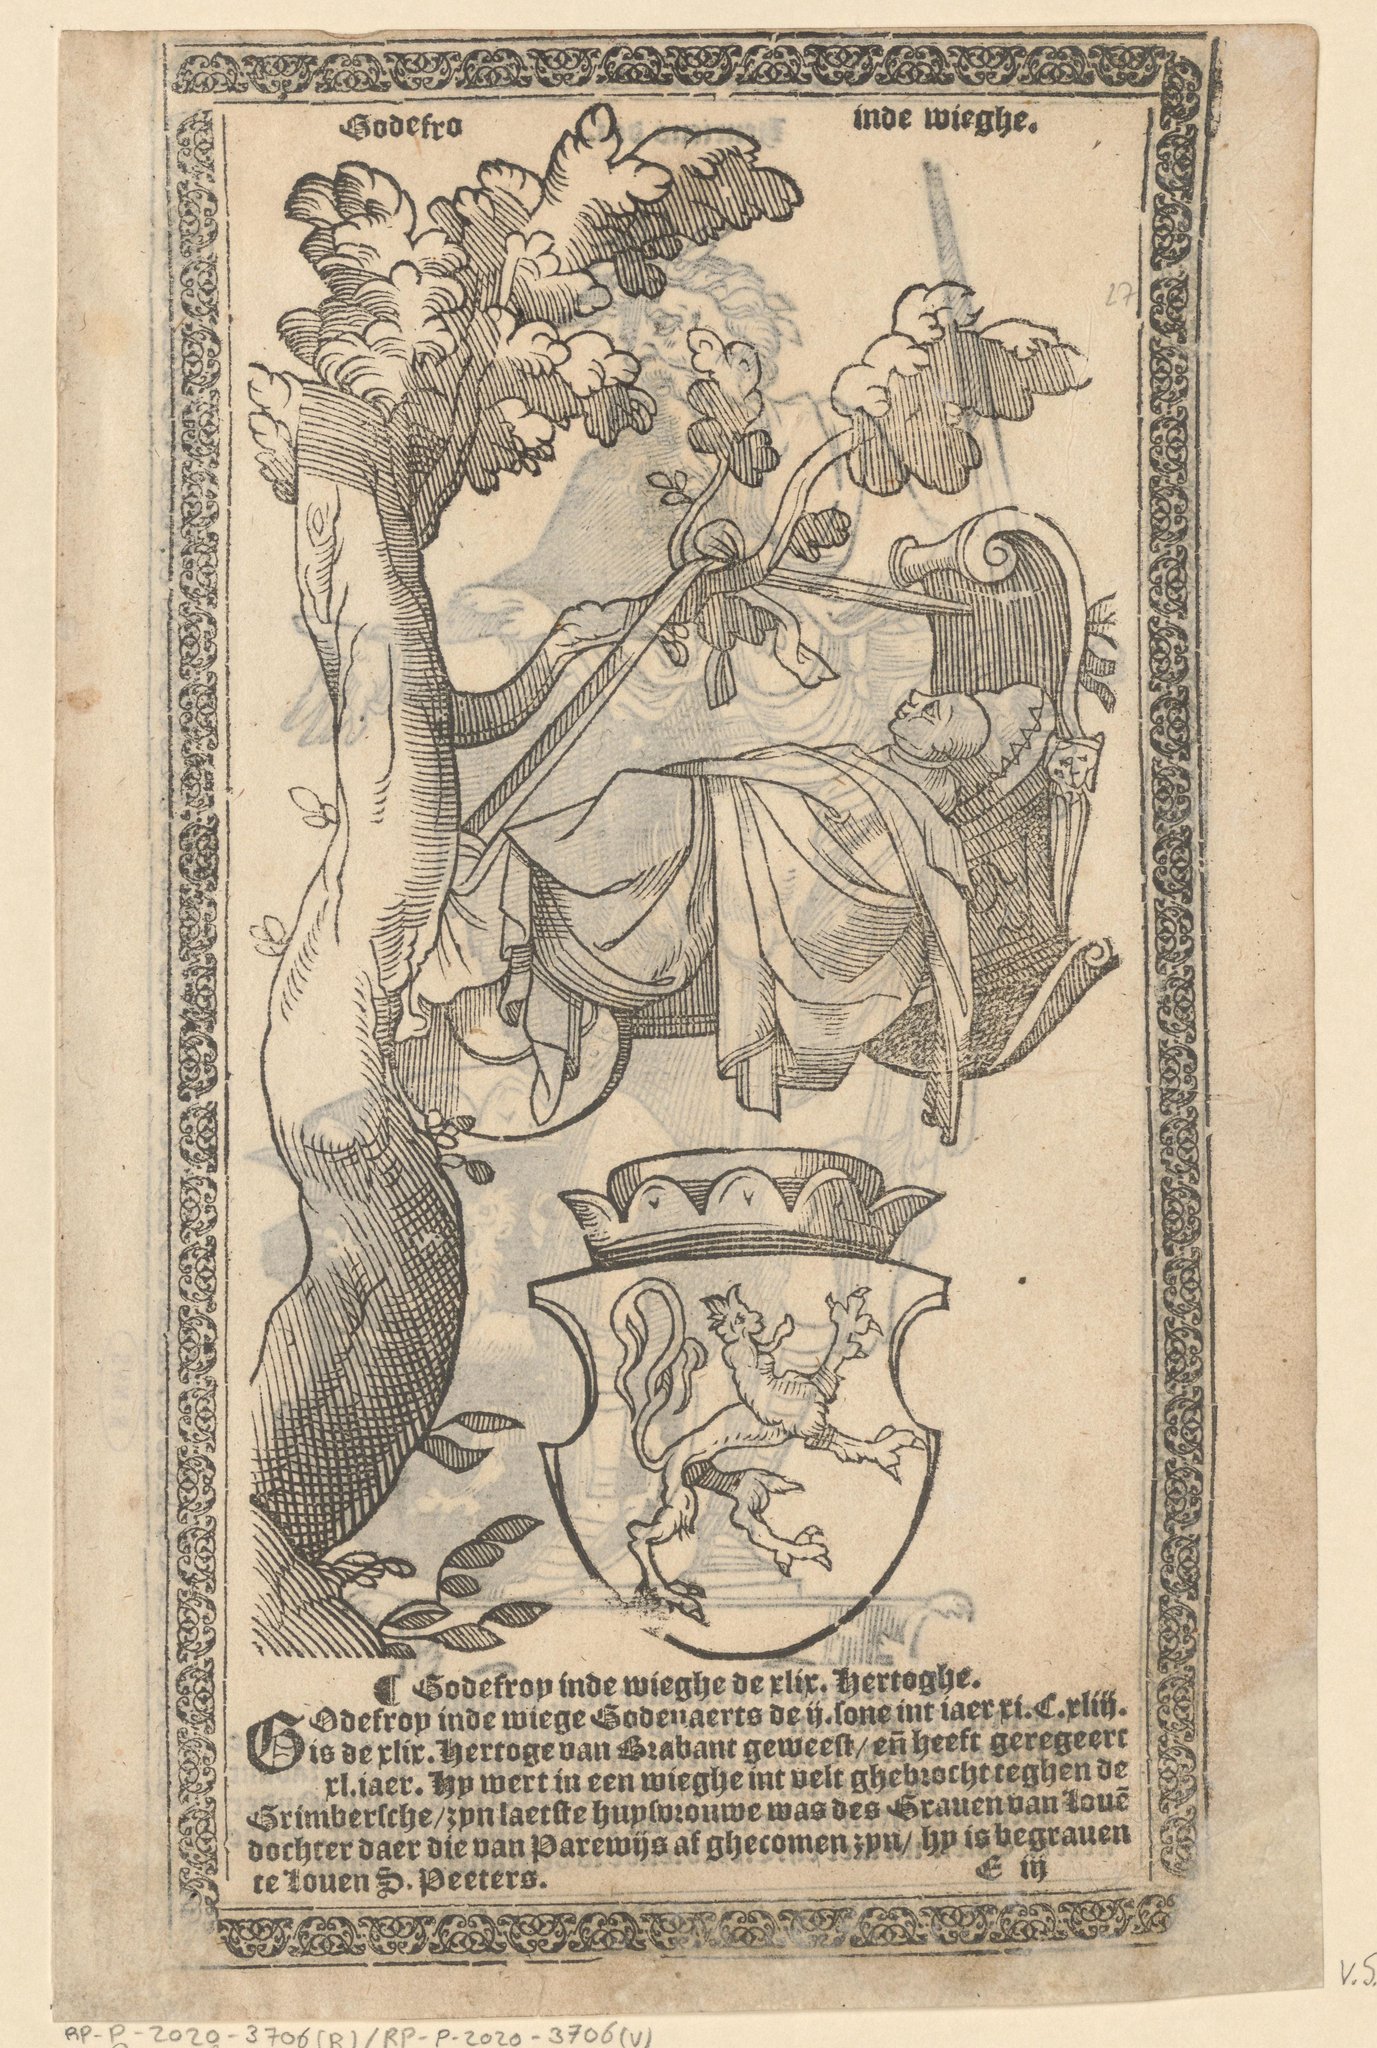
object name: print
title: Portret van Godfried III van Leuven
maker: jan molijns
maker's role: print maker, publisher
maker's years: 1498-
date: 1565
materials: paper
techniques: letterpress printing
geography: antwerp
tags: trees, historical persons, cradle, crib, armorial bearing, heraldry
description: Prent uit: Dit is die afcoemste ende genalogie der hertoghen ende hertoginnen van Brabandt, (...). Antwerpen: Jan Molijns, 1565.